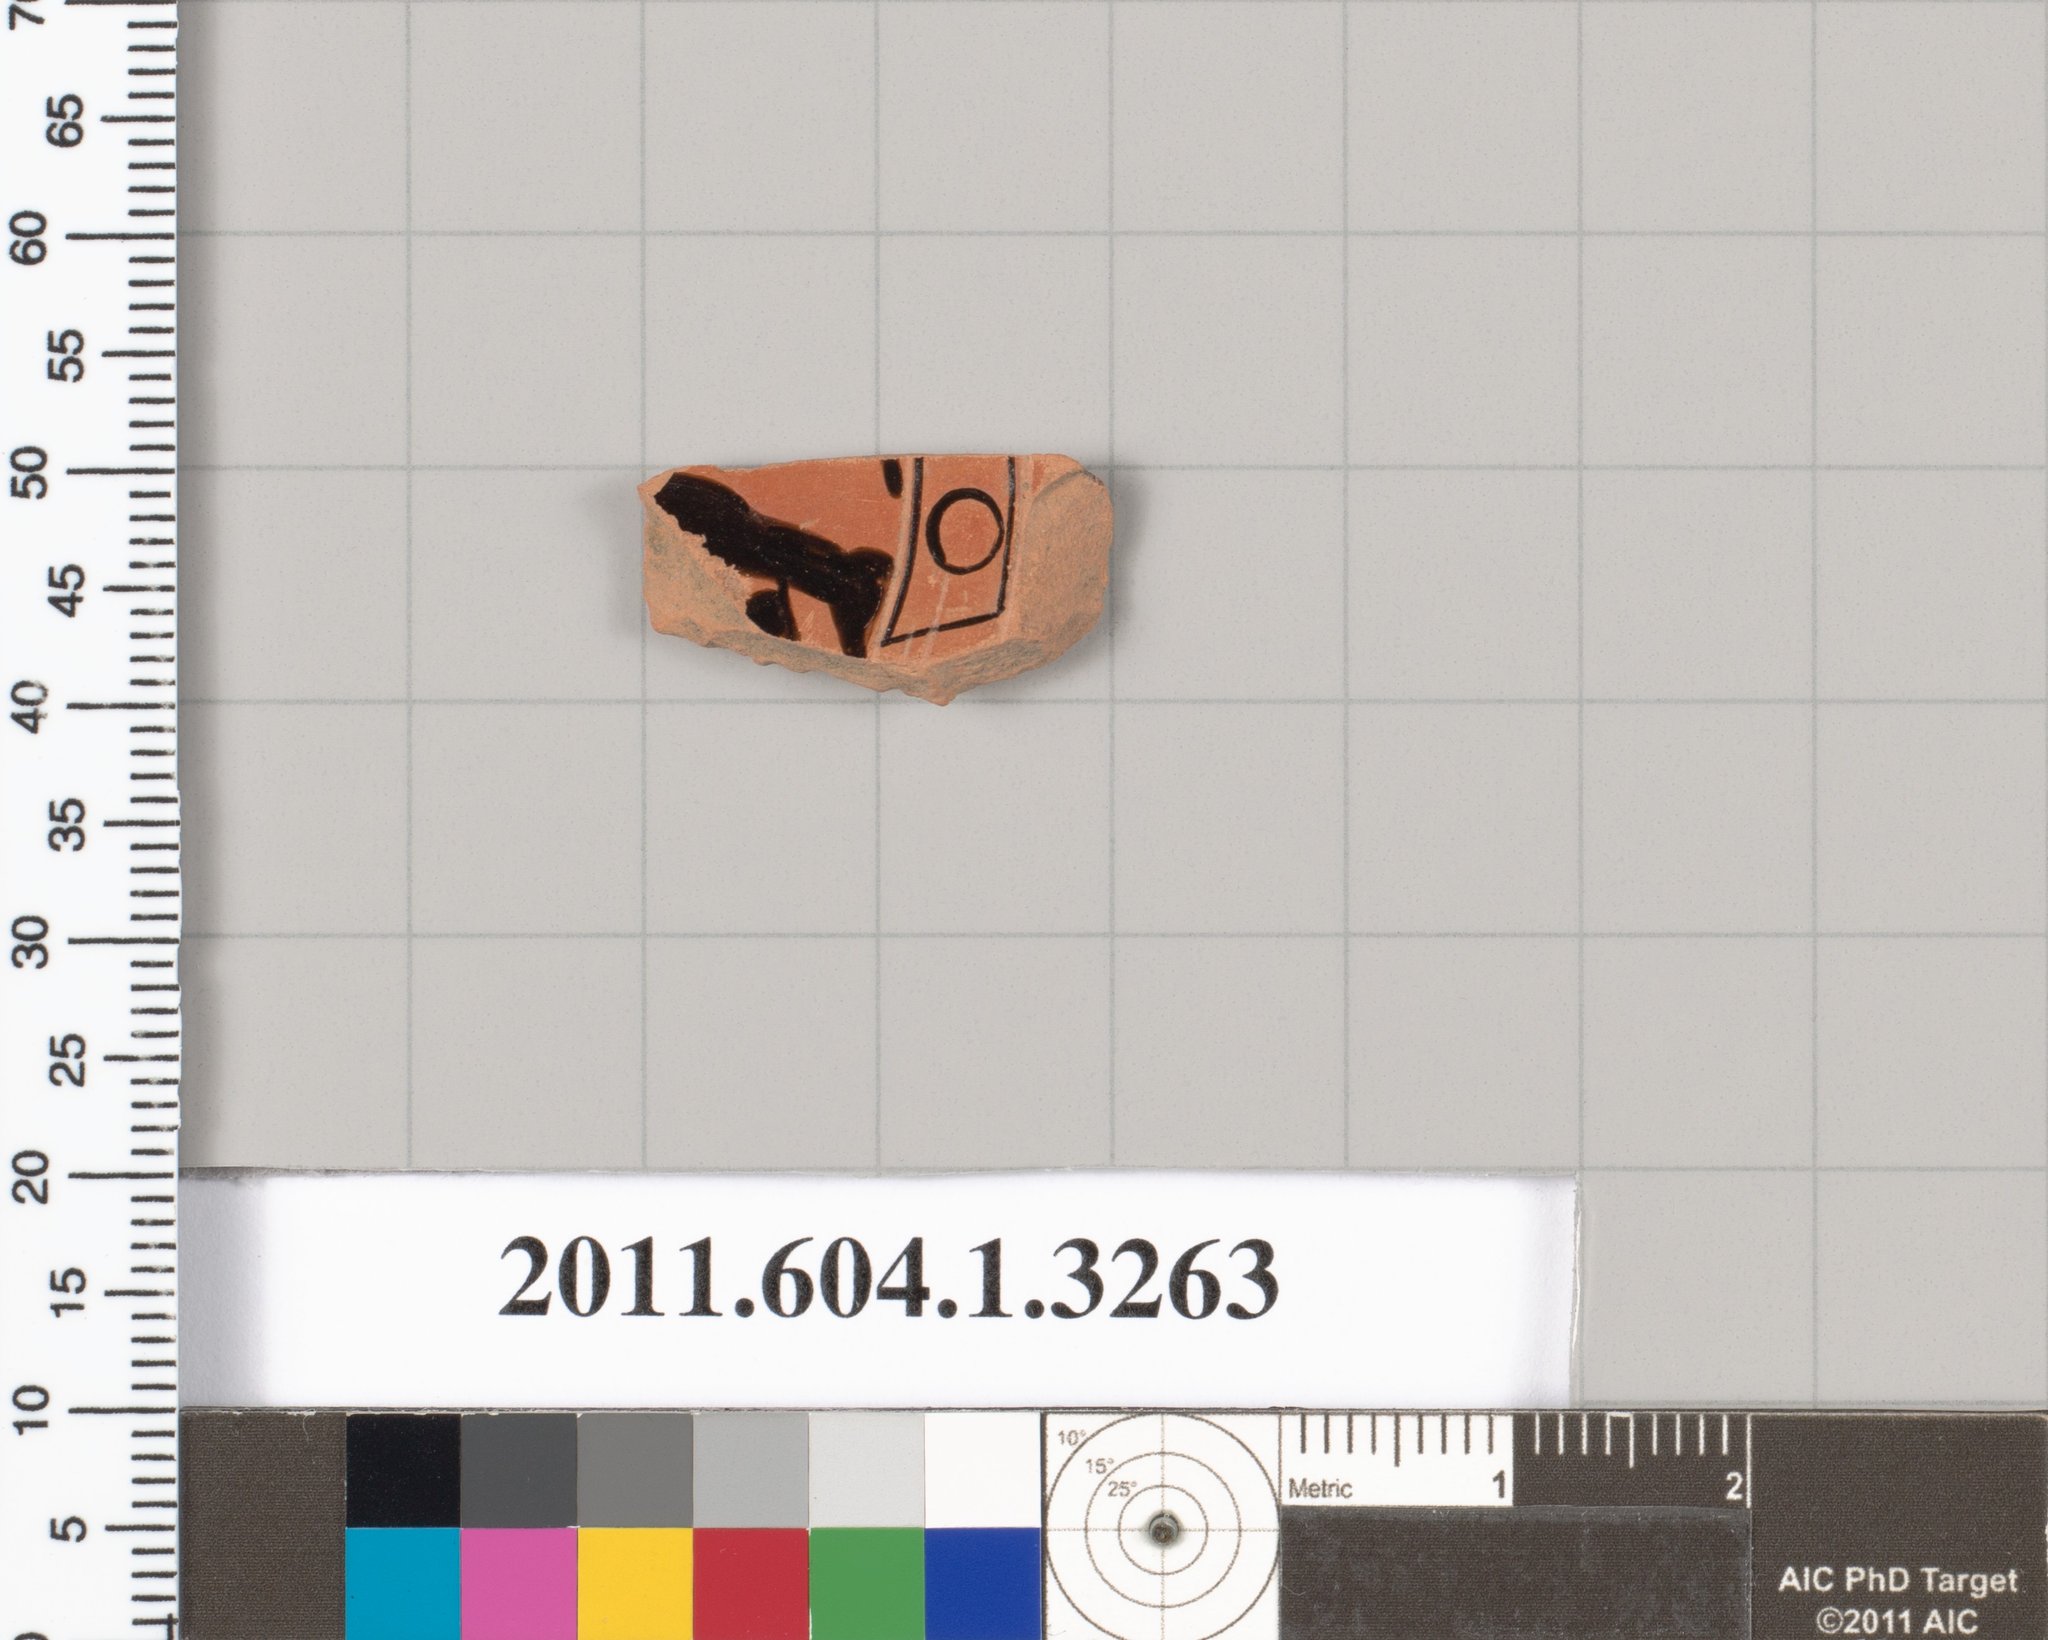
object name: kylix fragment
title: Terracotta fragment of a kylix (drinking cup)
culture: greek, attic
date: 500-451 BCE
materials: terracotta